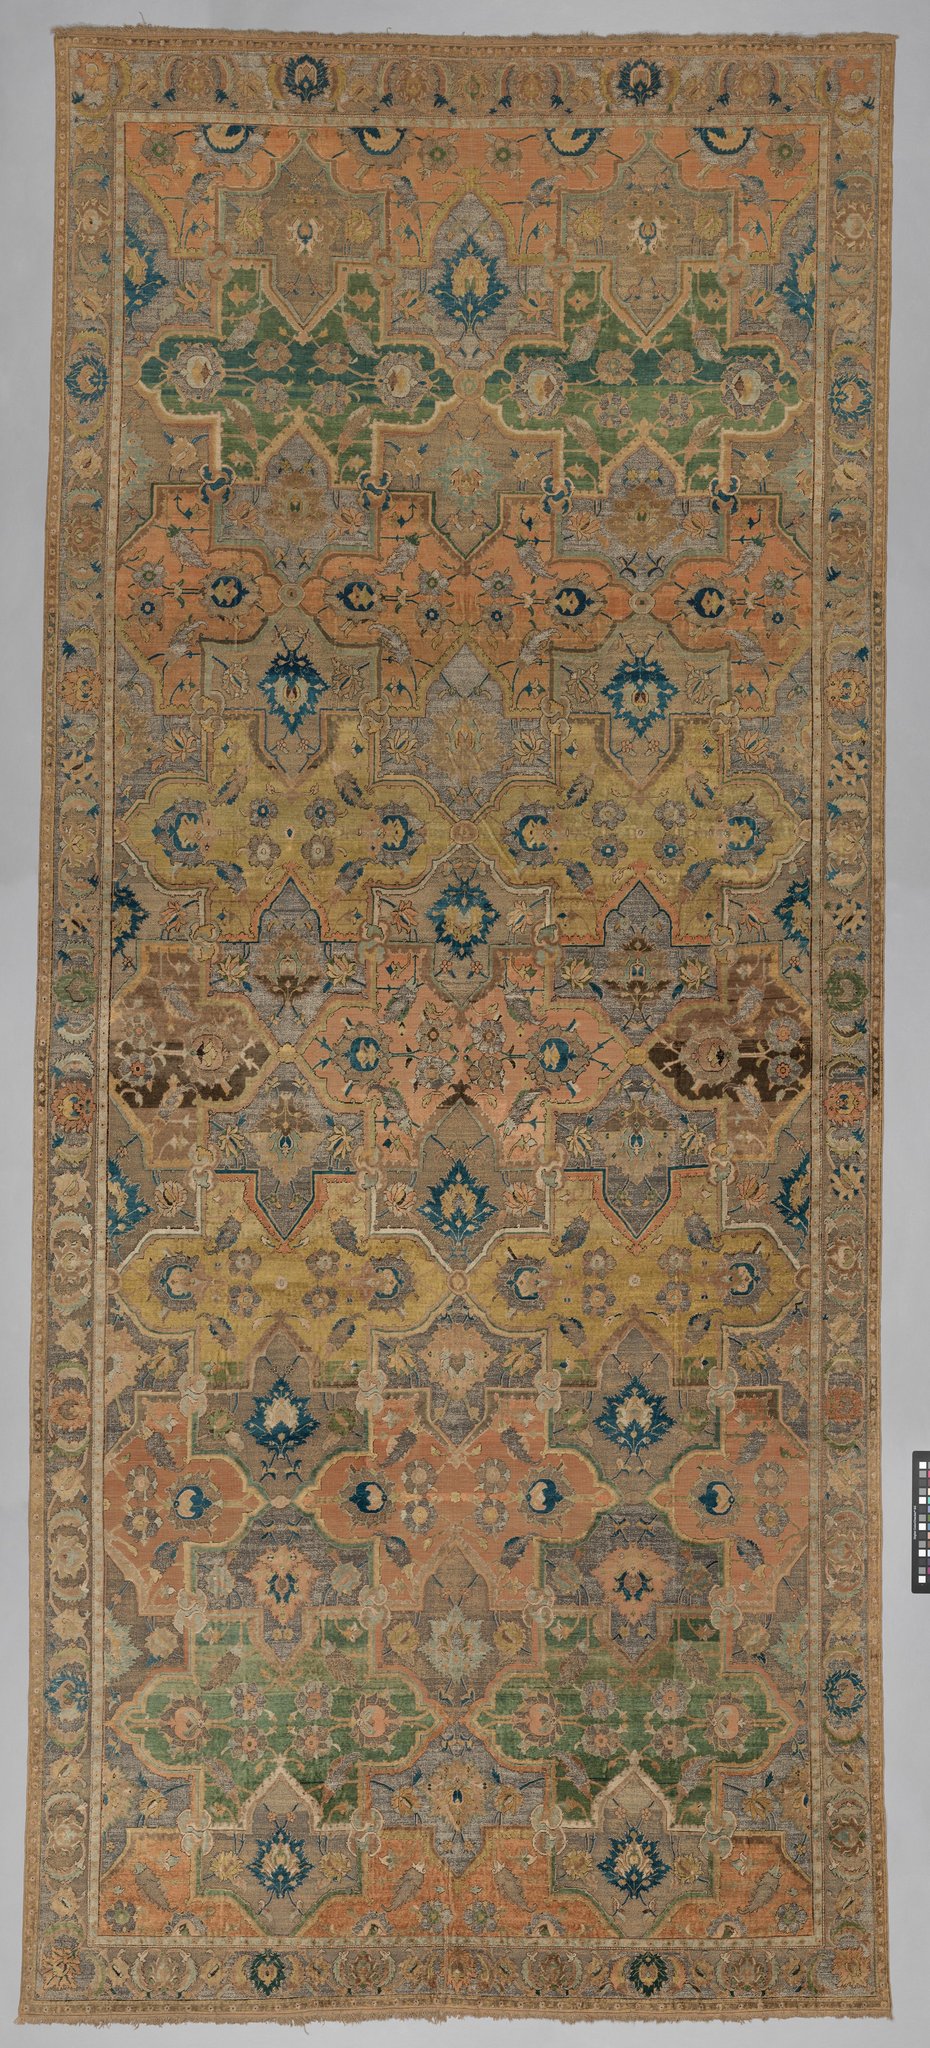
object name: carpet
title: Polonaise Carpet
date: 1601-1700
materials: cotton, metal thread, silk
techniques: asymmetrically knotted pile, brocade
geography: iran